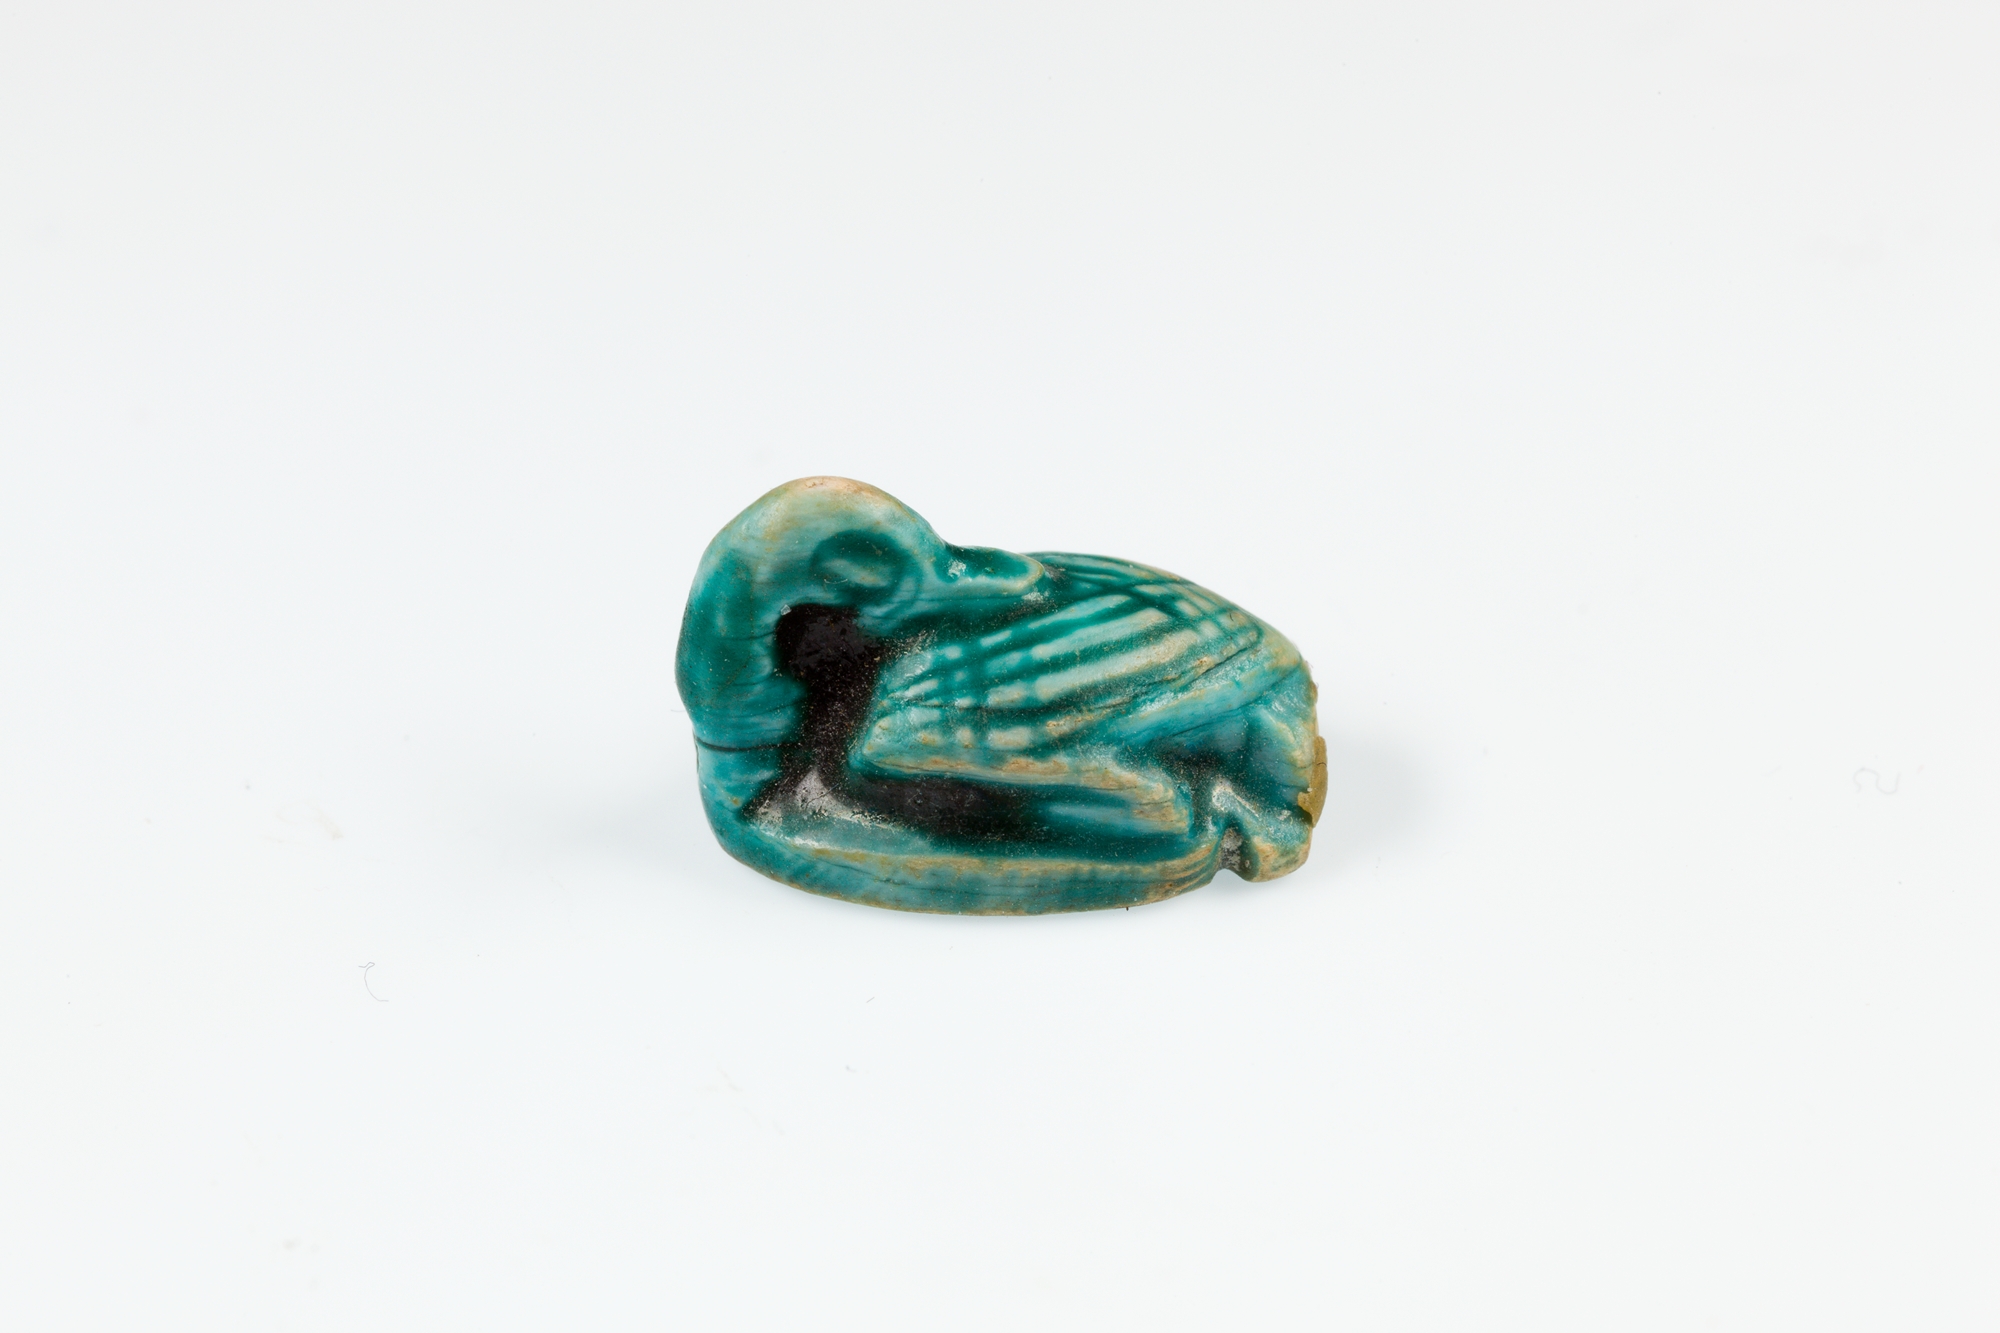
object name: seal, duck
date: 1492-1479 BCE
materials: stone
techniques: glazing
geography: egypt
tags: ducks